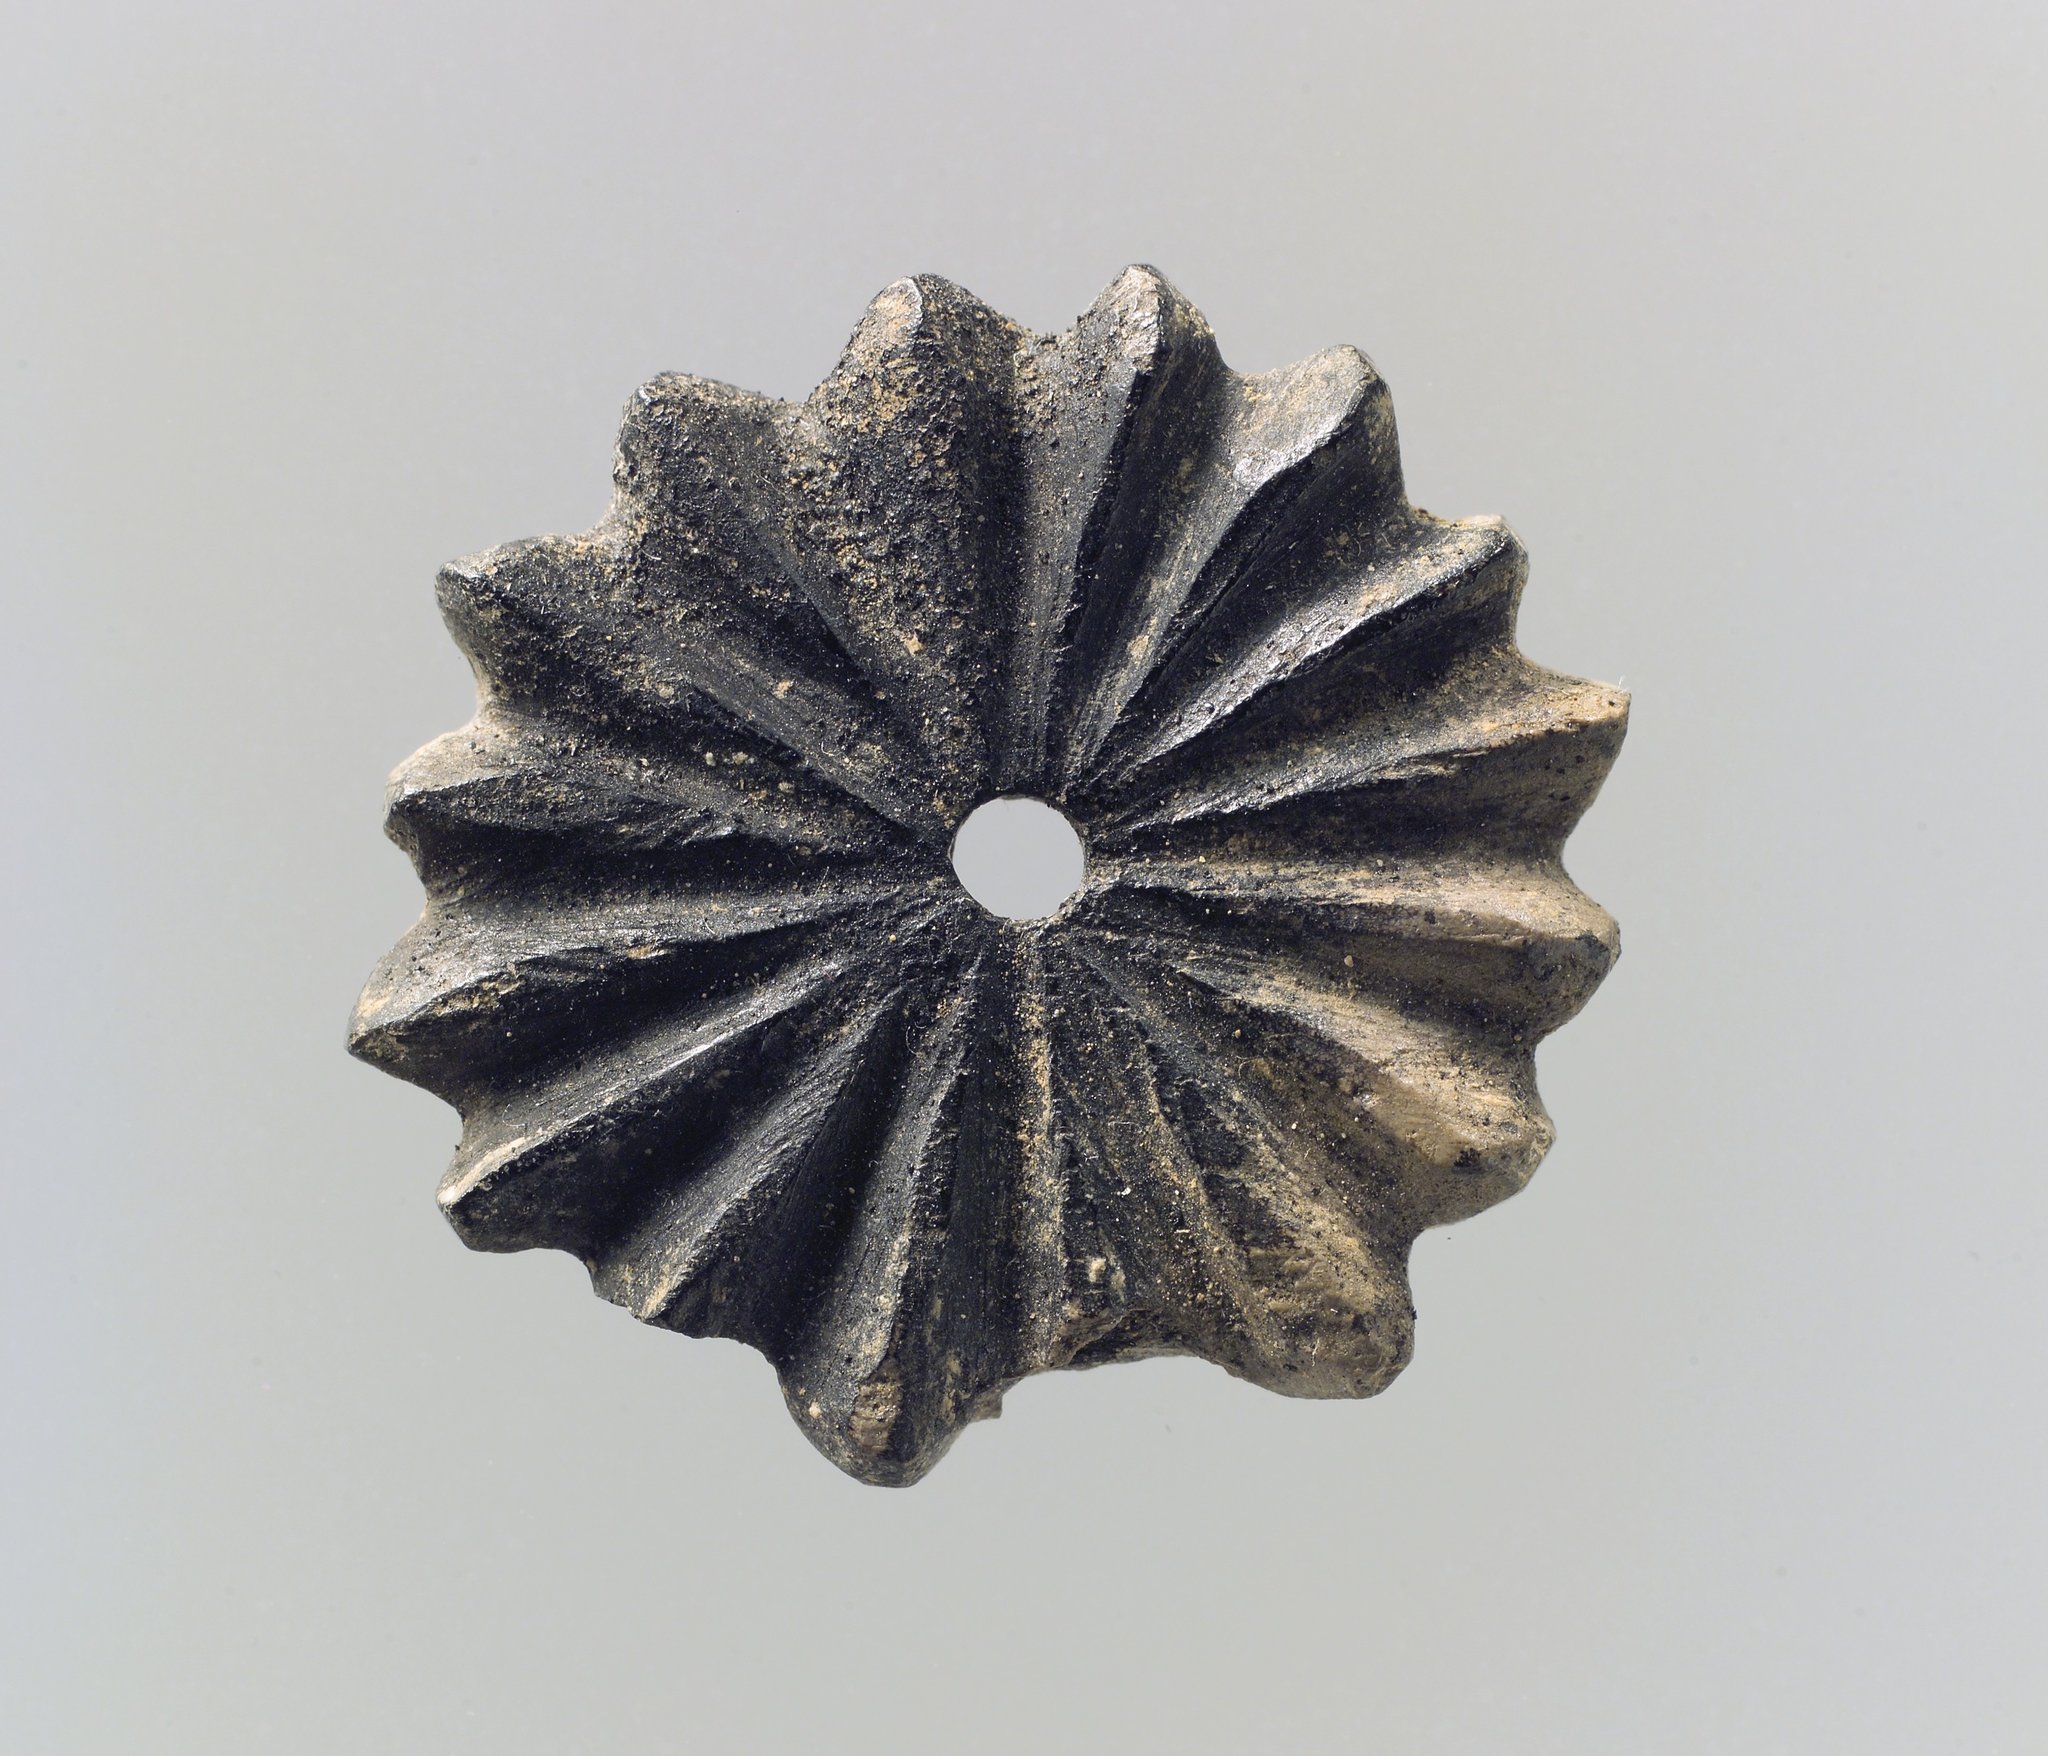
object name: inlay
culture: iranian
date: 800-601 BCE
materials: ivory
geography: iran